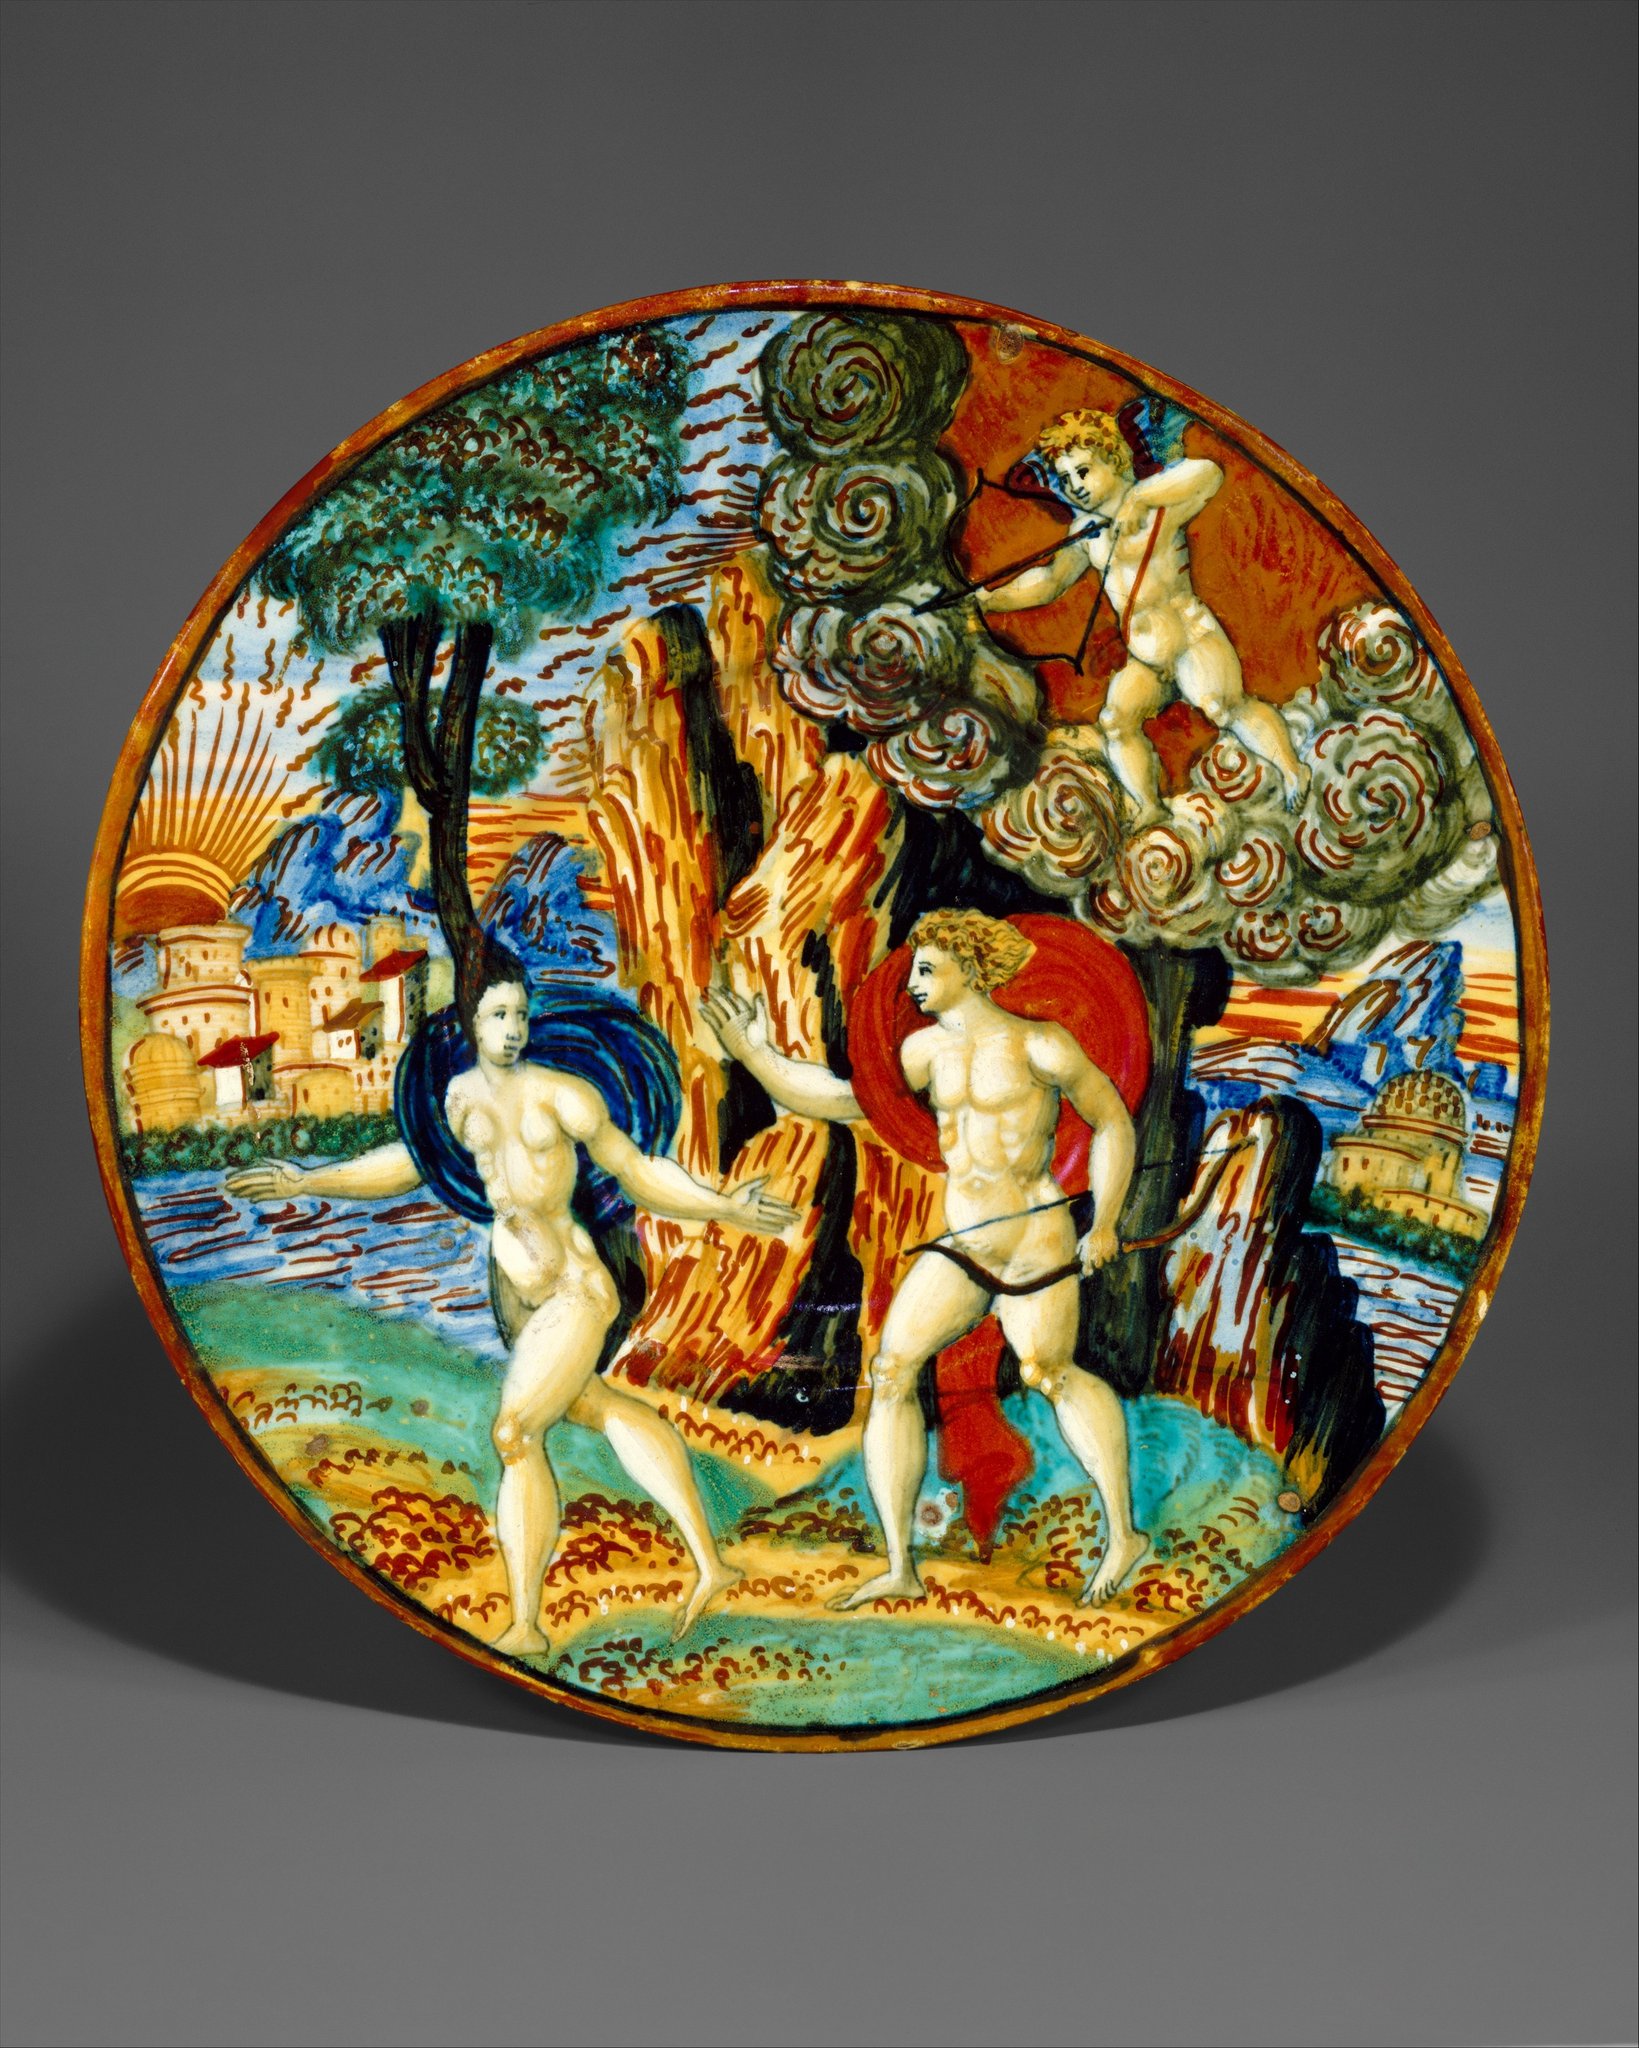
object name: dish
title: Dish (tondino)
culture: italian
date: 1530-1540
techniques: maiolica, glazing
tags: male nudes,female nudes,cupid